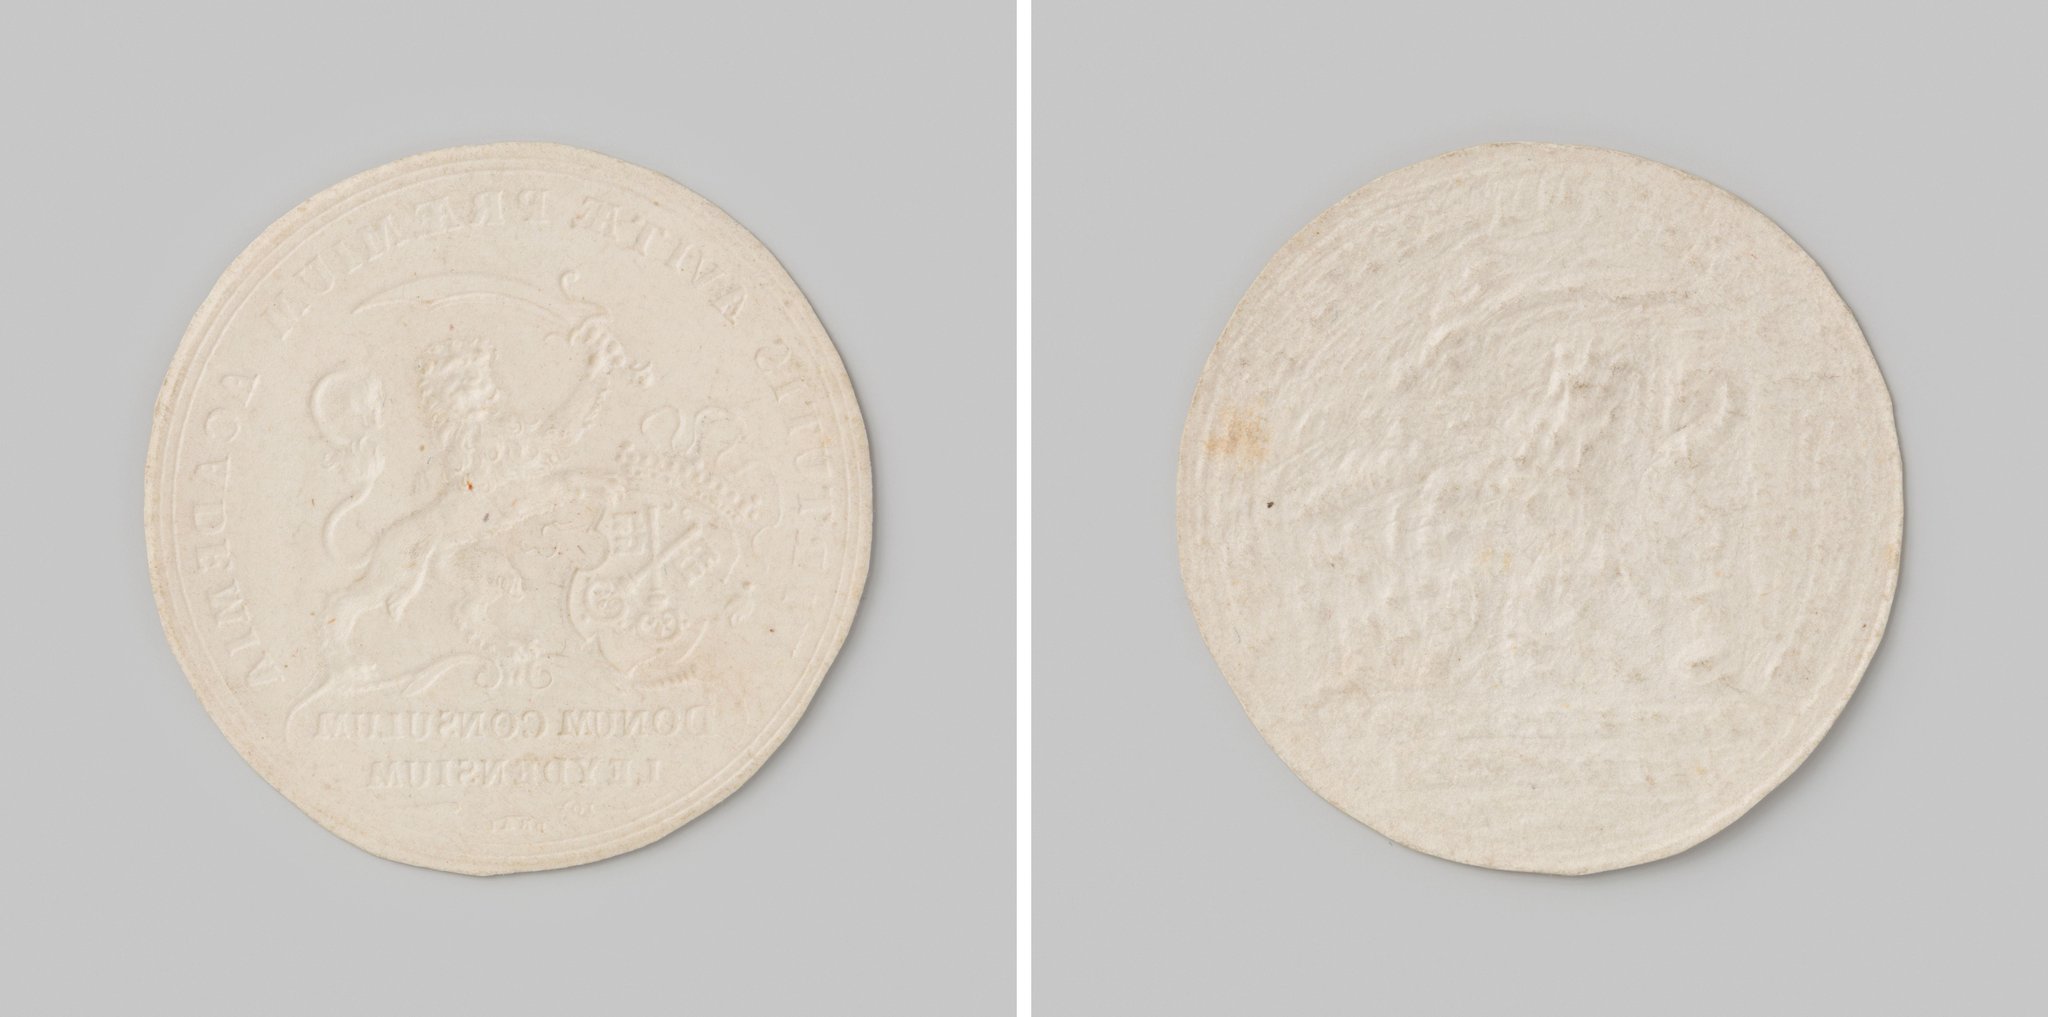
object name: beloningspenning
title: Beloningspenning van de Leidse burgemeesters voor promoties "met de kap", afdruk keerzijde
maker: johannes drappentier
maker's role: die cutter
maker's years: 1689-1758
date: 1695-1715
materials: cardboard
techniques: pressing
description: Kartonnen afdruk van de voorzijde, leeuw met wapenschild Leiden en geheven zwaard, met omschrift en afsnedetekst